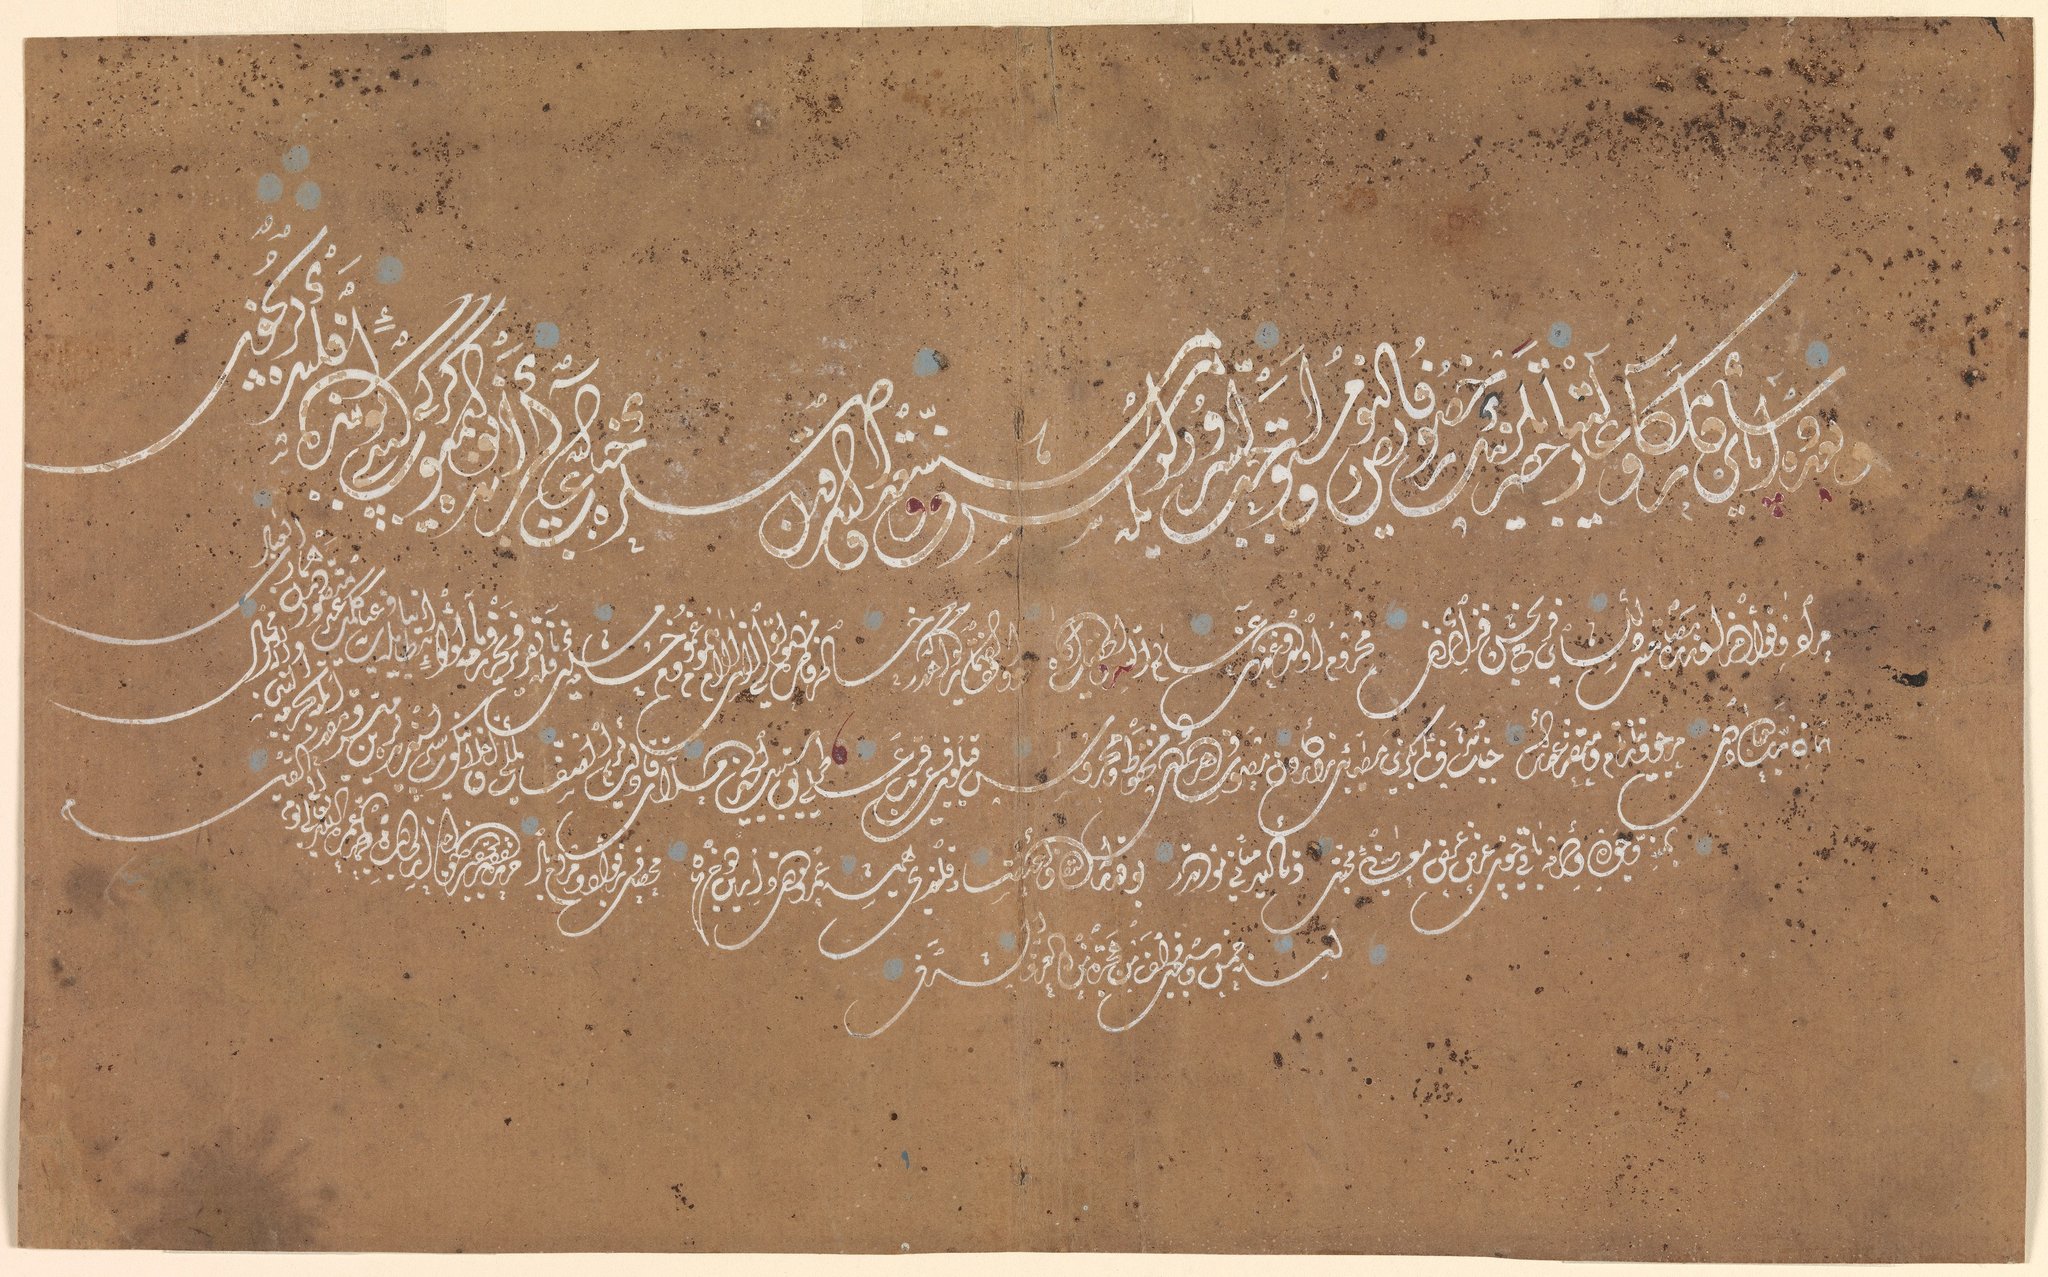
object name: non illustrated single work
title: Page of Calligraphy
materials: ink, paper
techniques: dyeing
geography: turkey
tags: calligraphy